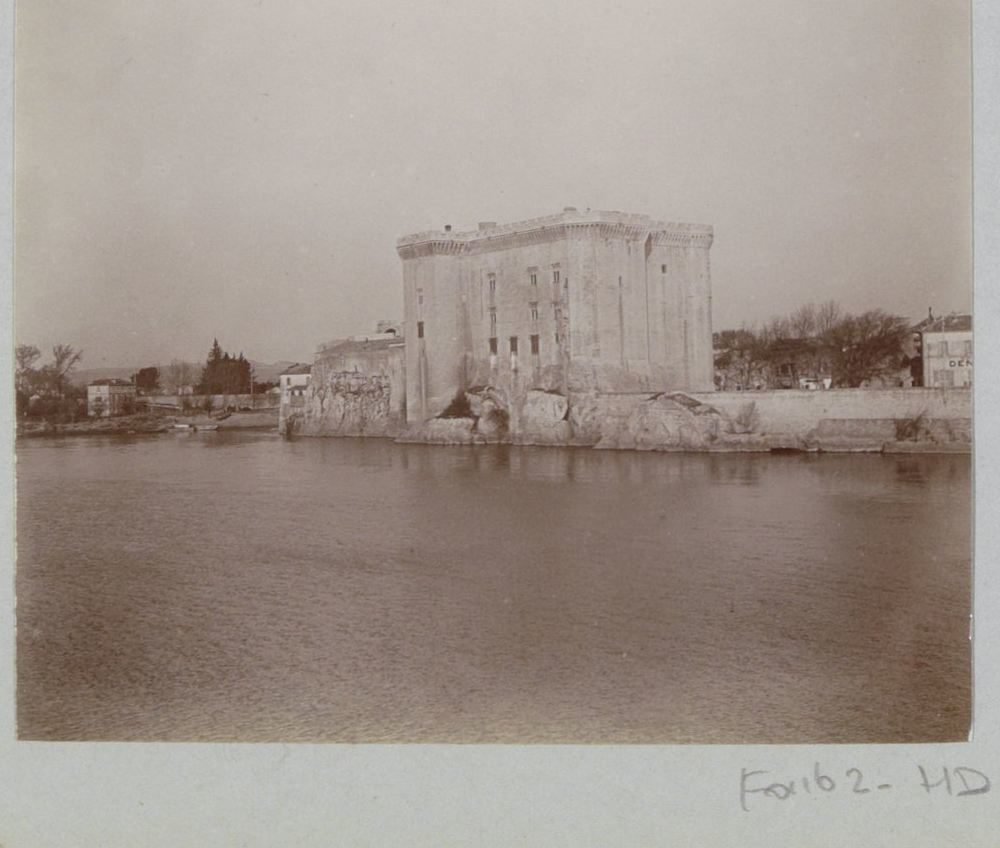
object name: photograph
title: Gebouw aan een water, vermoedelijk in Zuid-Frankrijk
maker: Anonymous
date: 1905-1910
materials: paper, photographic support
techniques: gelatin silver print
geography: southern france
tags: exterior ~ representation of a building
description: Onderdeel van Fotoalbum van een Franse amateurfotograaf met bezienswaardigheden in Frankrijk, Zwitserland en Italië.